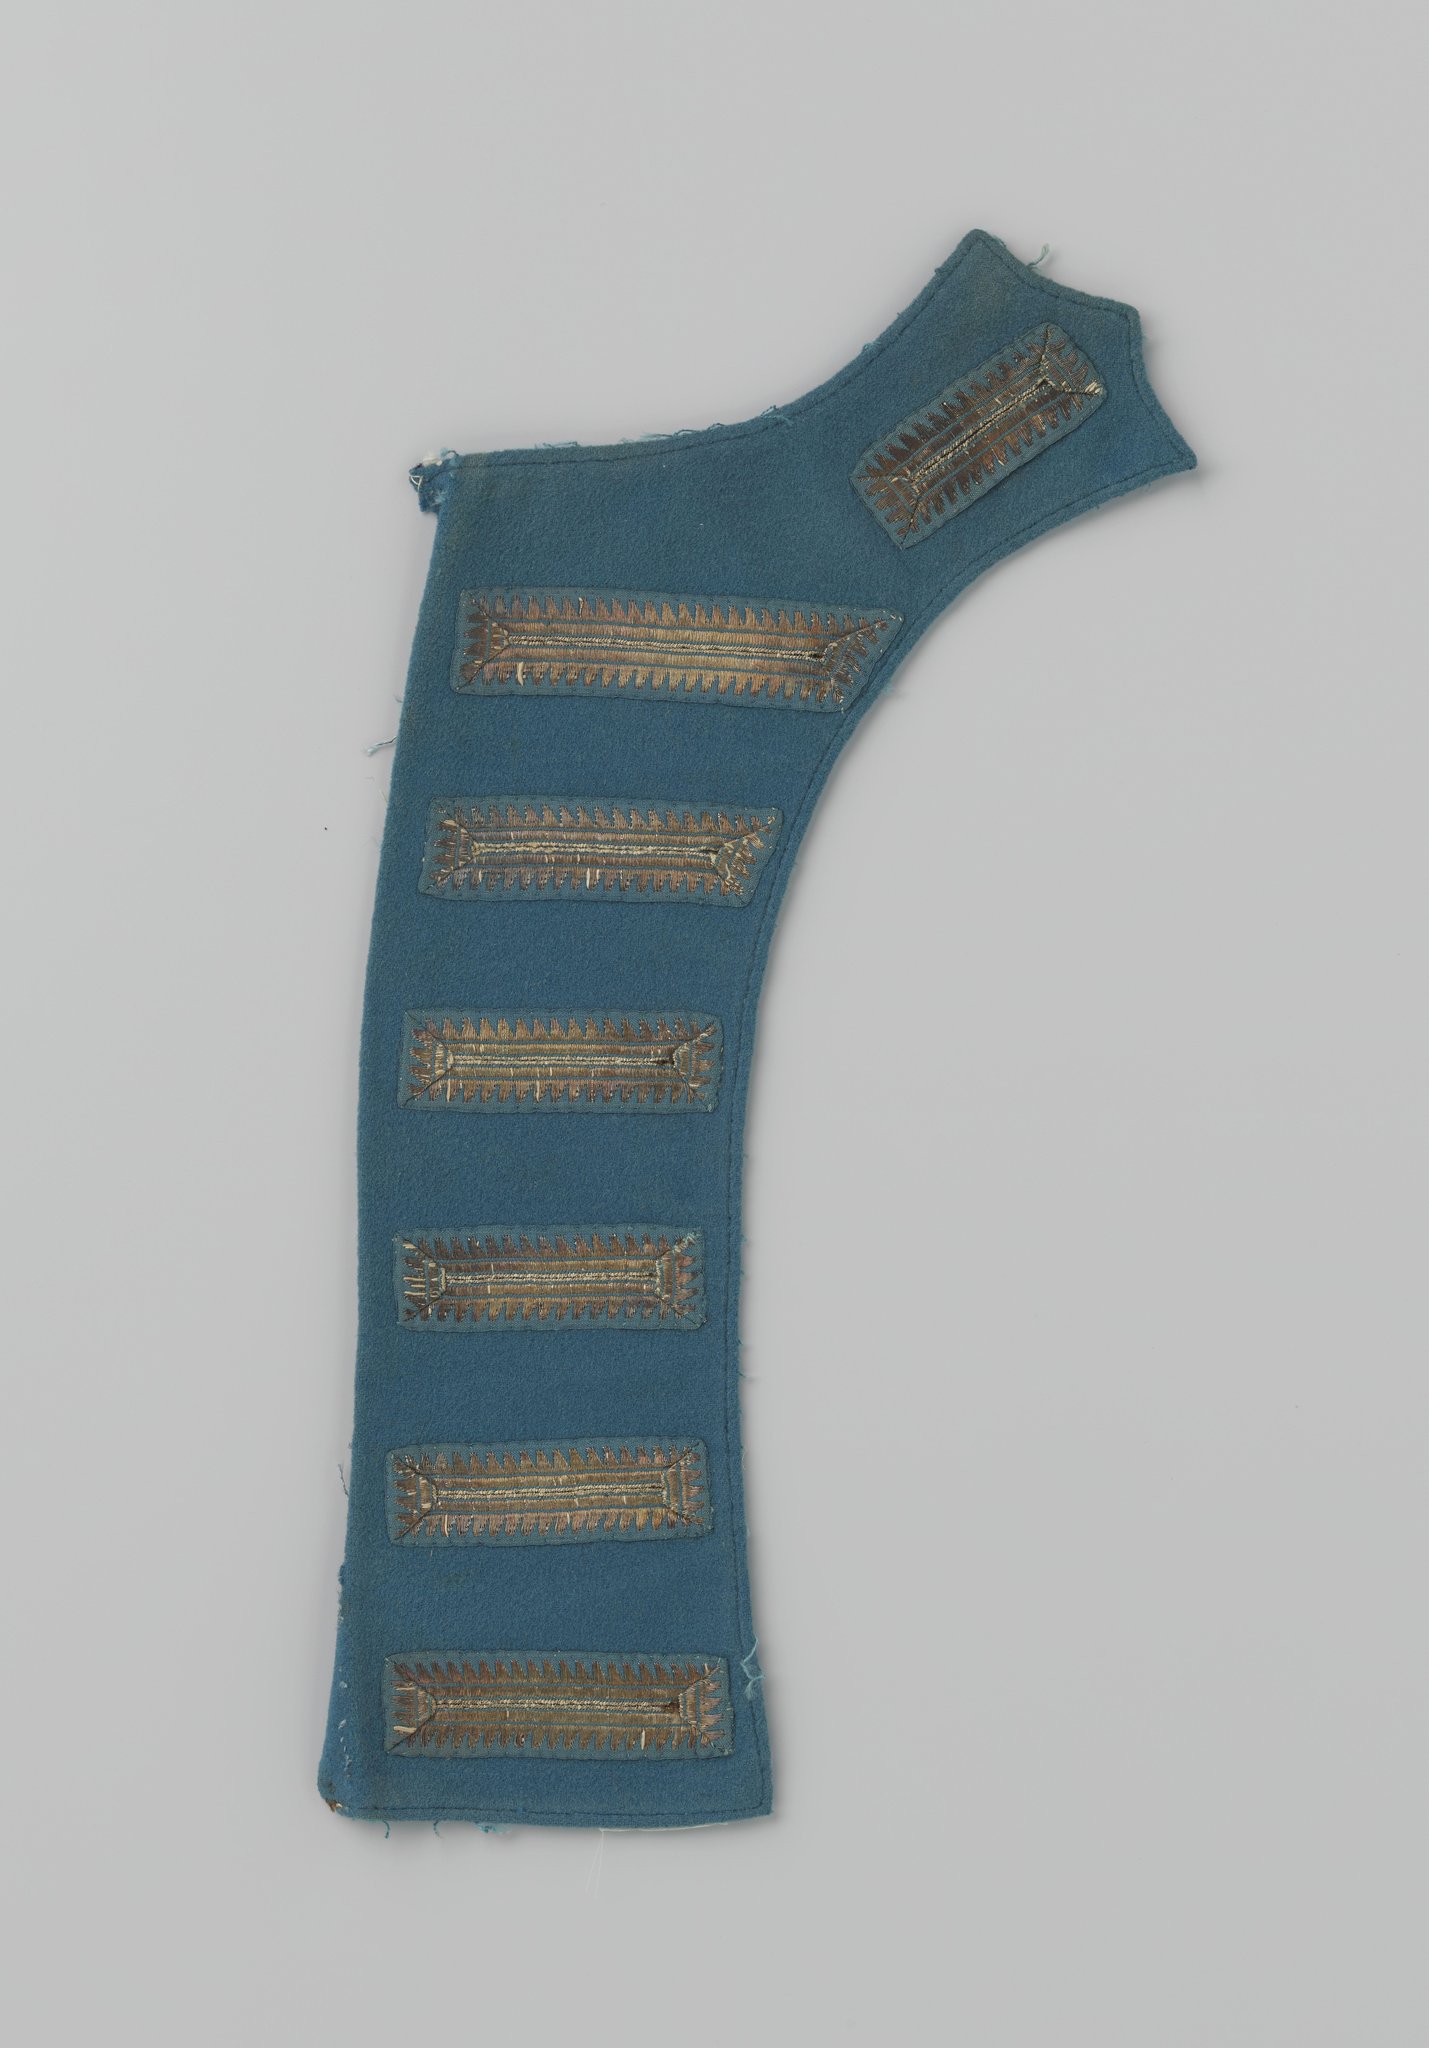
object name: fragment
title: Revers van blauw laken met zeven applicaties van zilverborduursel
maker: Anonymous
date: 1800-1825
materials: textile, thread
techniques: appliqué, embroidered, sewing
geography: netherlands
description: Uniformfragmenten bestaande uit: twee kragen, manchetomslagen, paar revers met één en zeven paar lissen, voering en rug- en voorpanden; voor livrei of schutterij (?). Deze uniformfragmenten waren op het moment van invoer nog niet beschikbaar en daar de aantallen e.d. onduidelijk zijn, is bij deze invoer alleen volstaan met de vermelding van de diverse onderdelen. De invoer per onderdeel moet dus nog volgen.